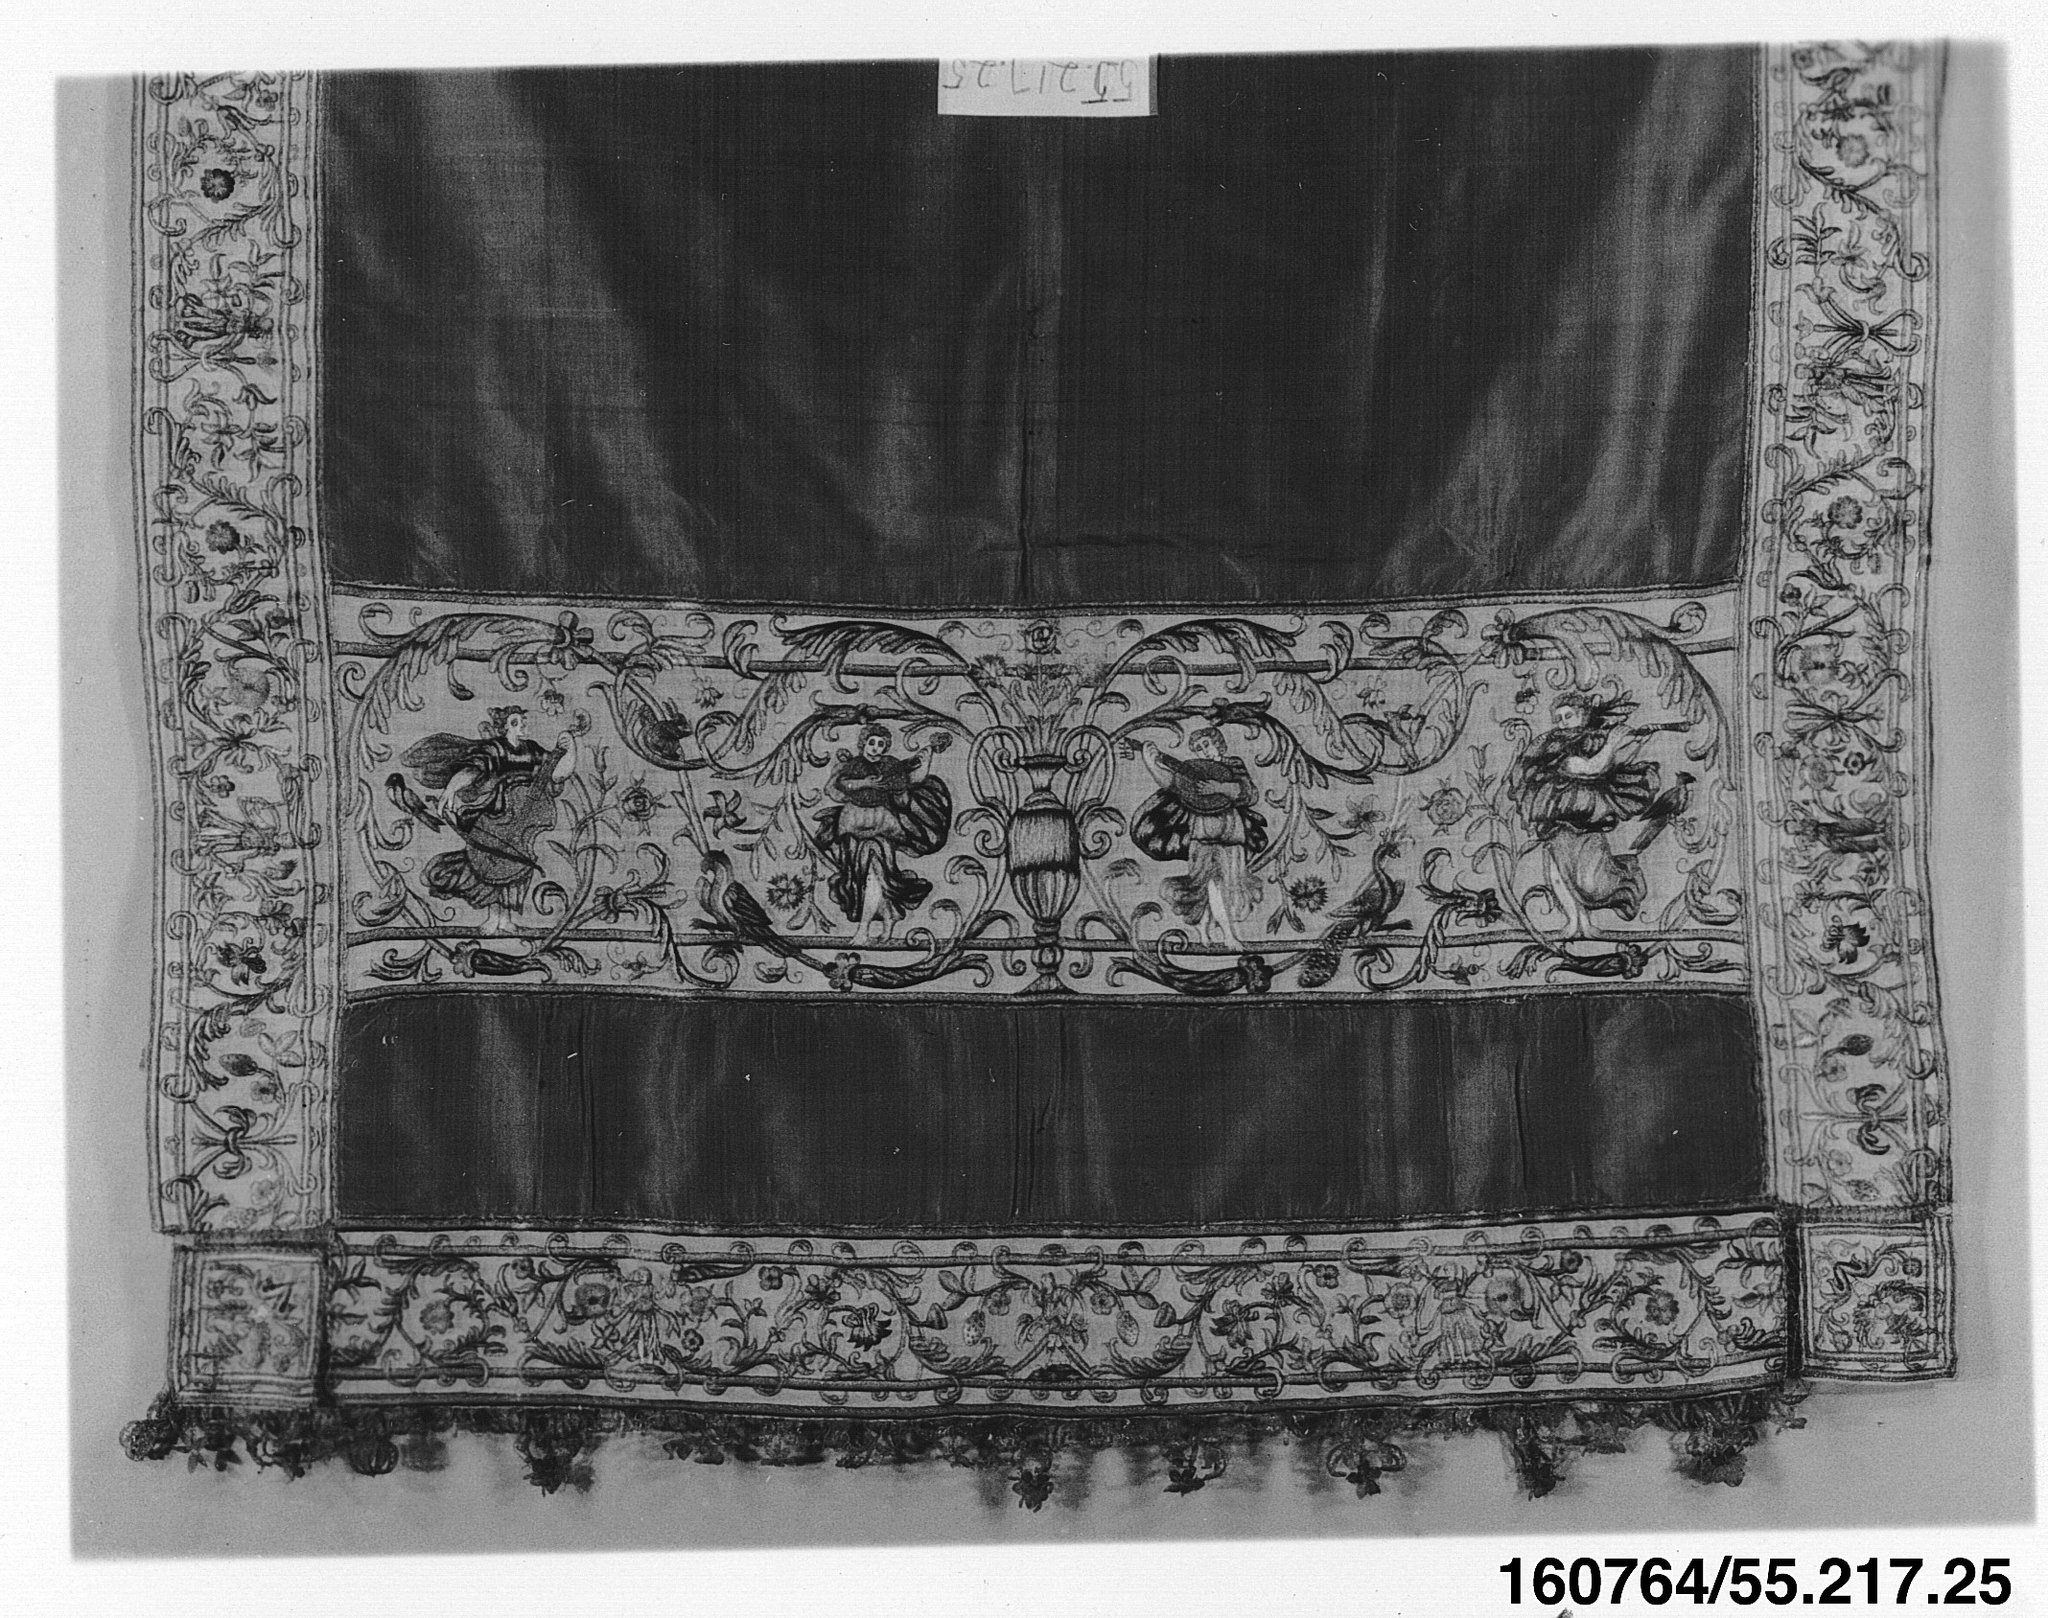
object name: cover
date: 1501-1600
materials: linen, metal thread, silk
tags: musical instruments,birds,men